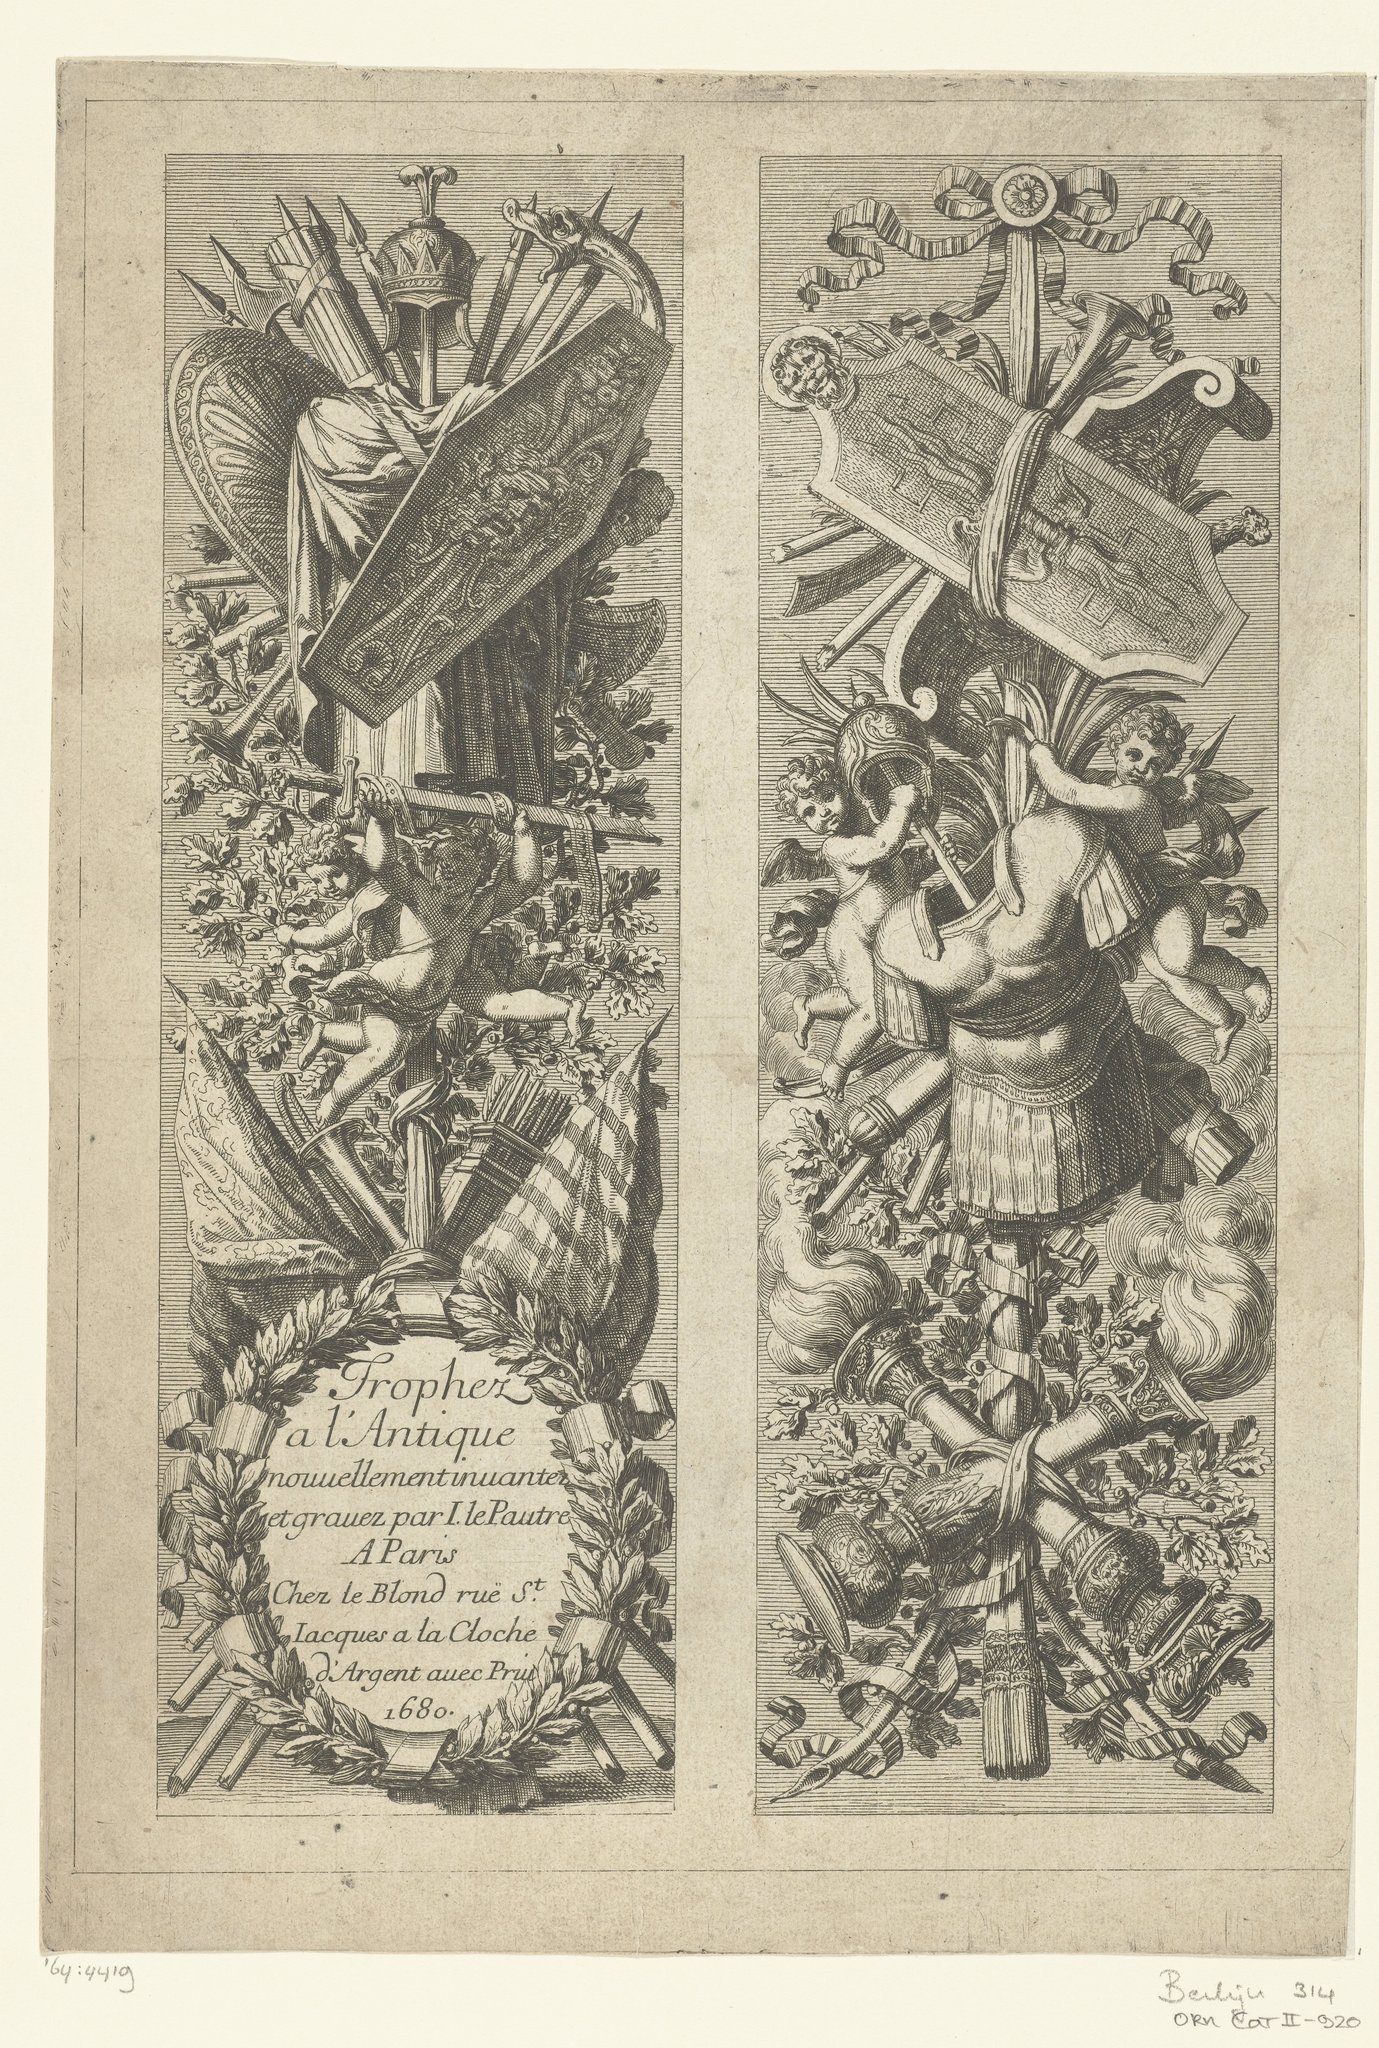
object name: ornament print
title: Trophez à l'Antique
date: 1680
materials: paper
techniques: etching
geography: france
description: Wapentrofeeën à l'antique, de titel staat onderaan de linkertrofee. Uit serie van 6 bladen, tweede editie.